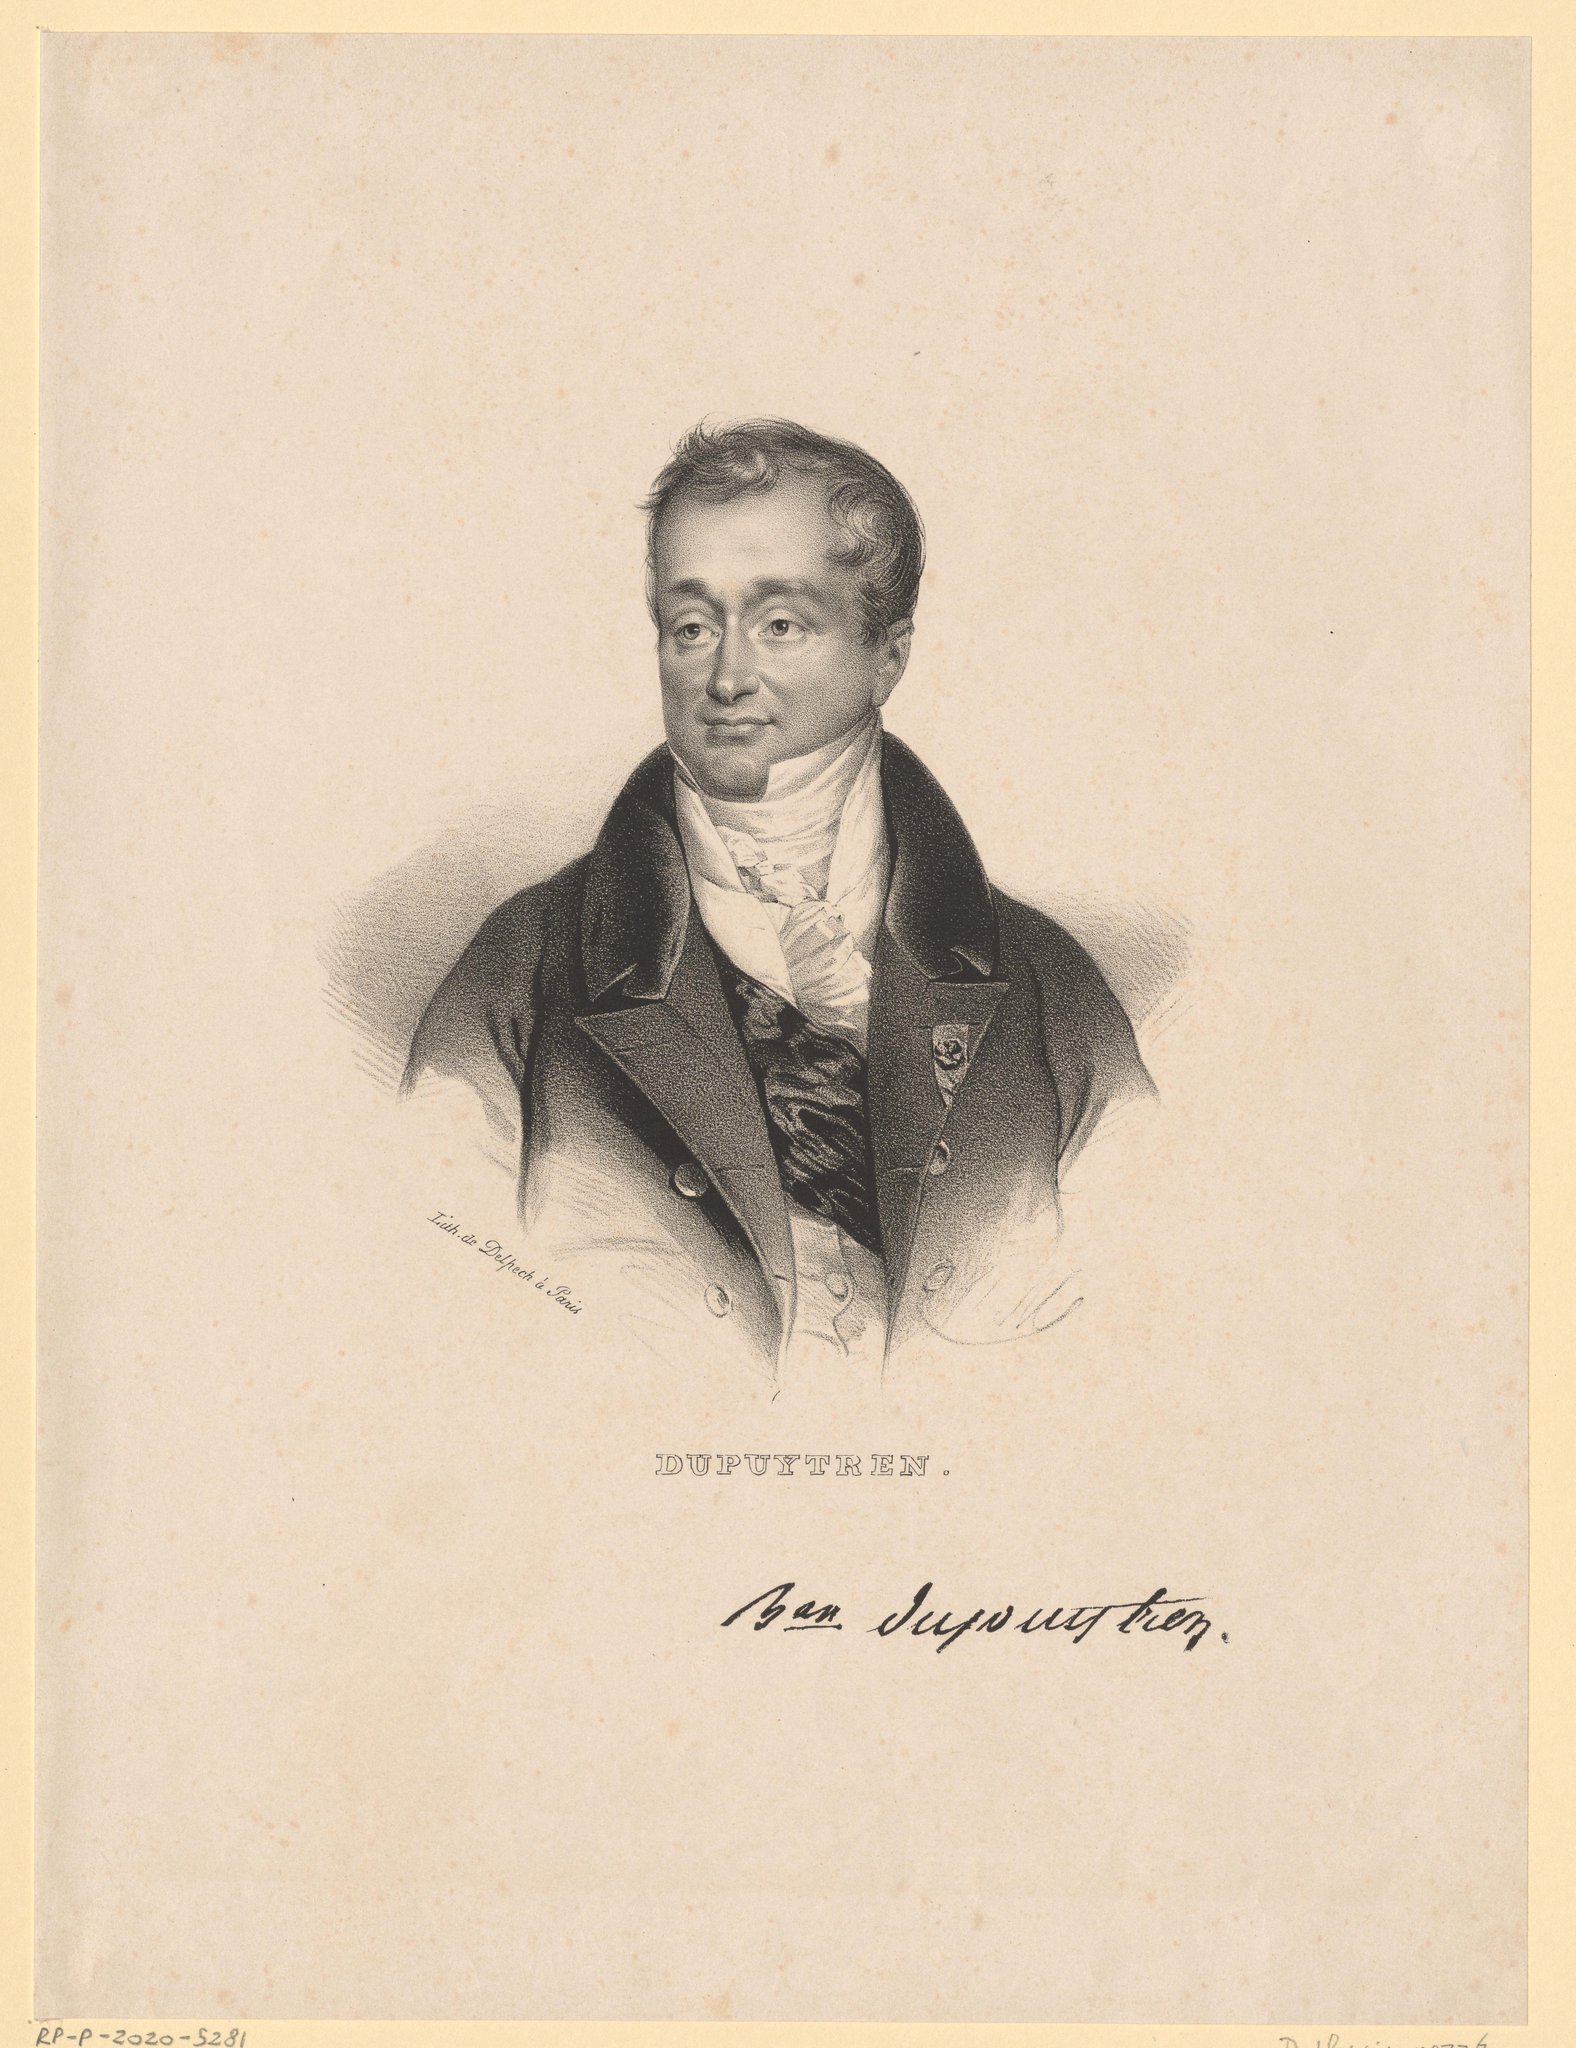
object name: print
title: Portret van Guillaume Dupuytren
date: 1826-1842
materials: paper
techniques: lithograph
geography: paris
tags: historical persons, barber; surgeon